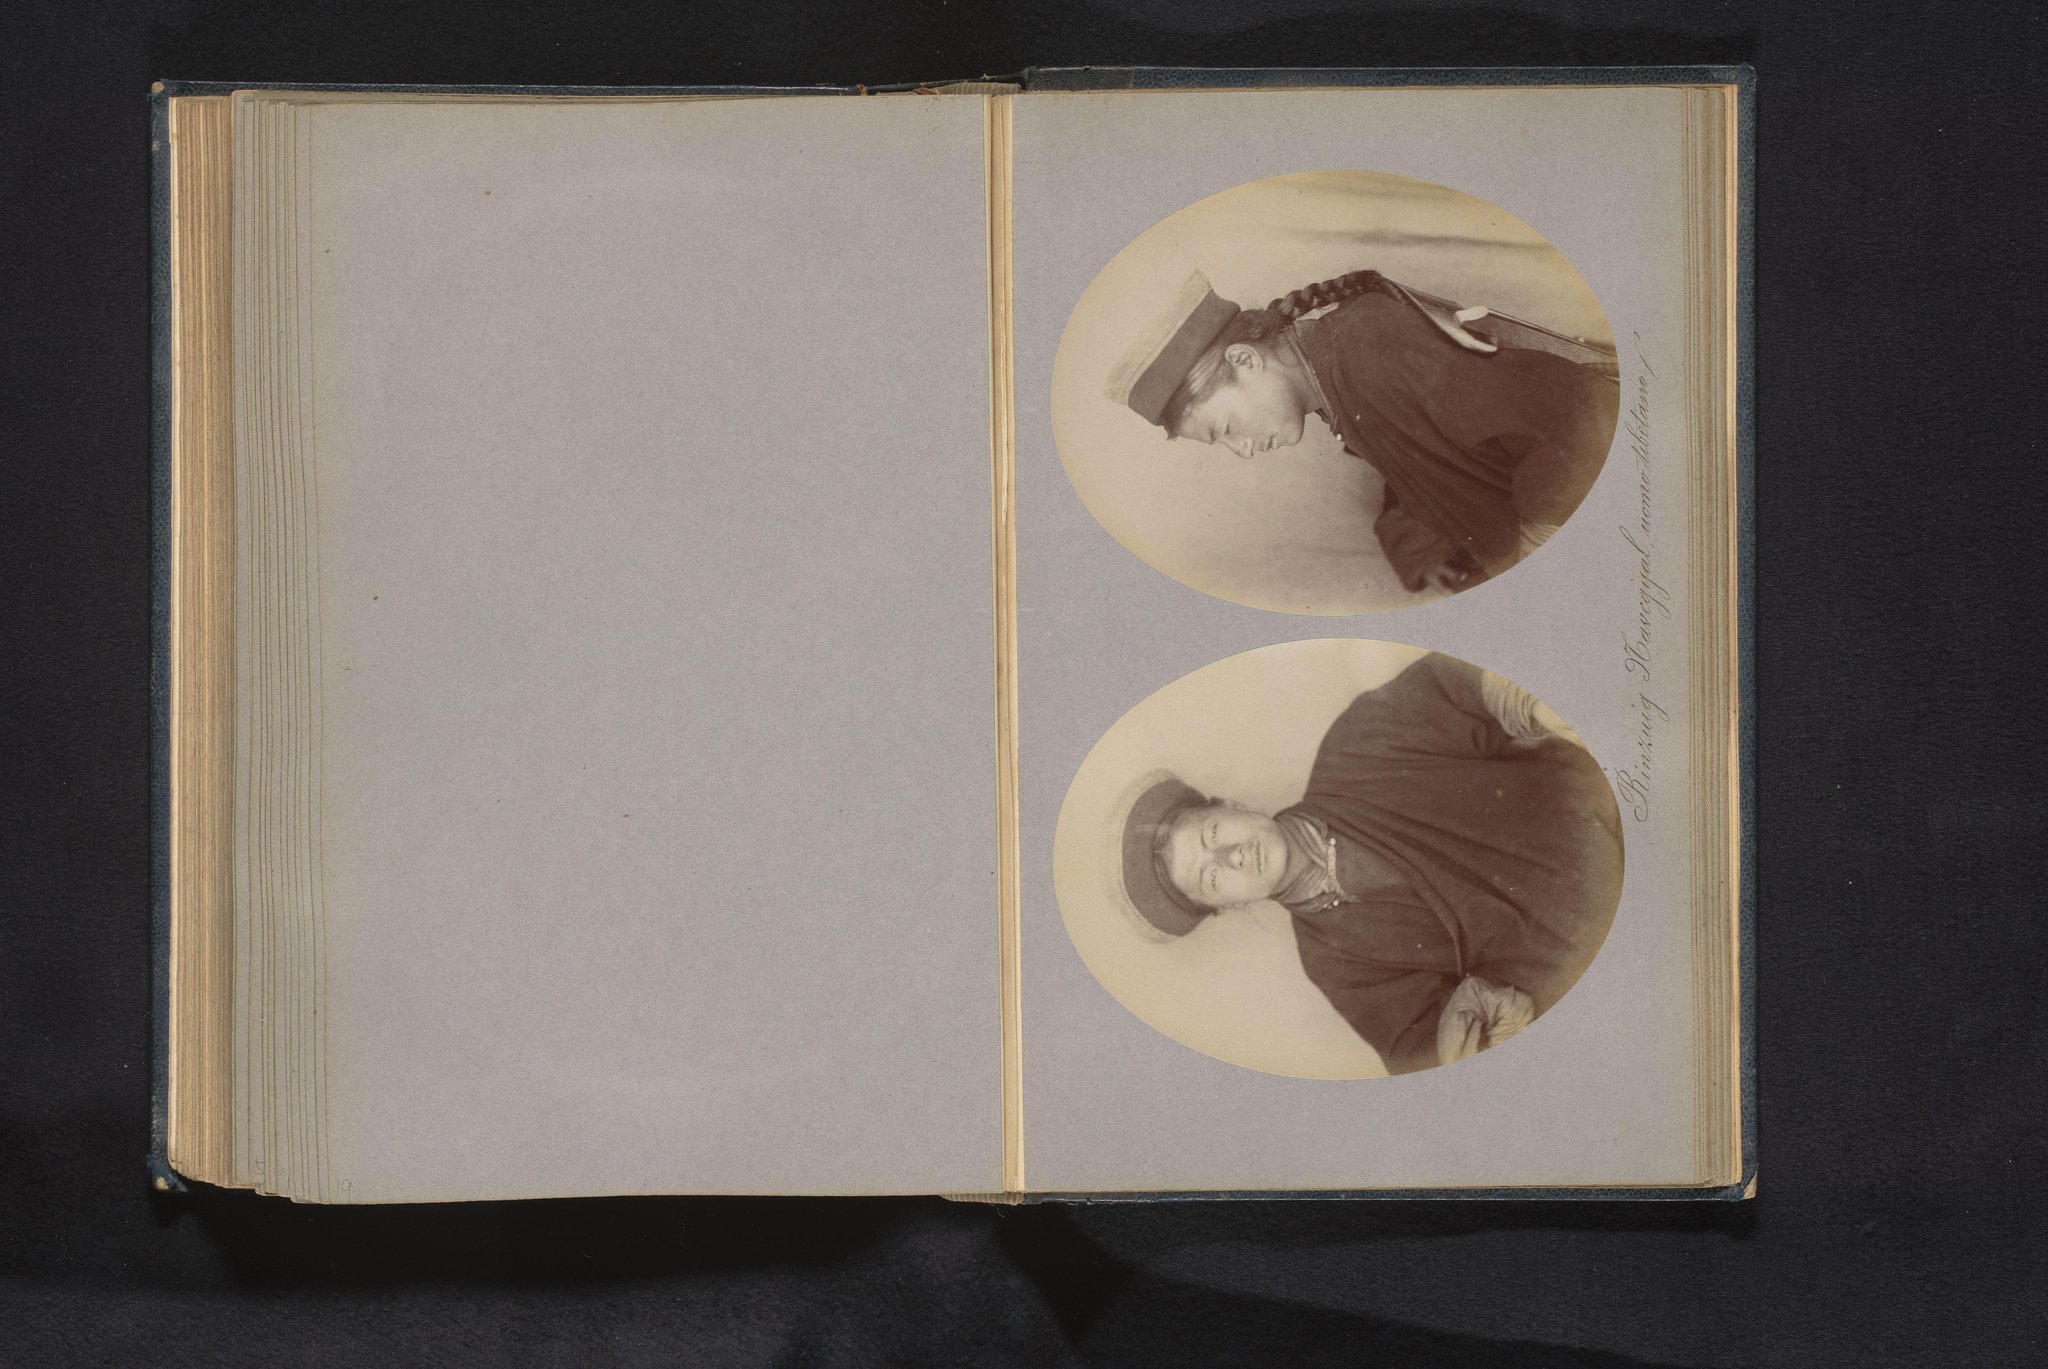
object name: photograph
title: Rinzuig Havegyal, uomo tibetano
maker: paolo mantegazza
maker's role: antropoloog, professor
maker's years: 1831-1910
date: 1881-1886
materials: photographic support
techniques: albumen print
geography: tibet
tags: head-gear, adult man (+ front view), adult man (+ sideview, profile)